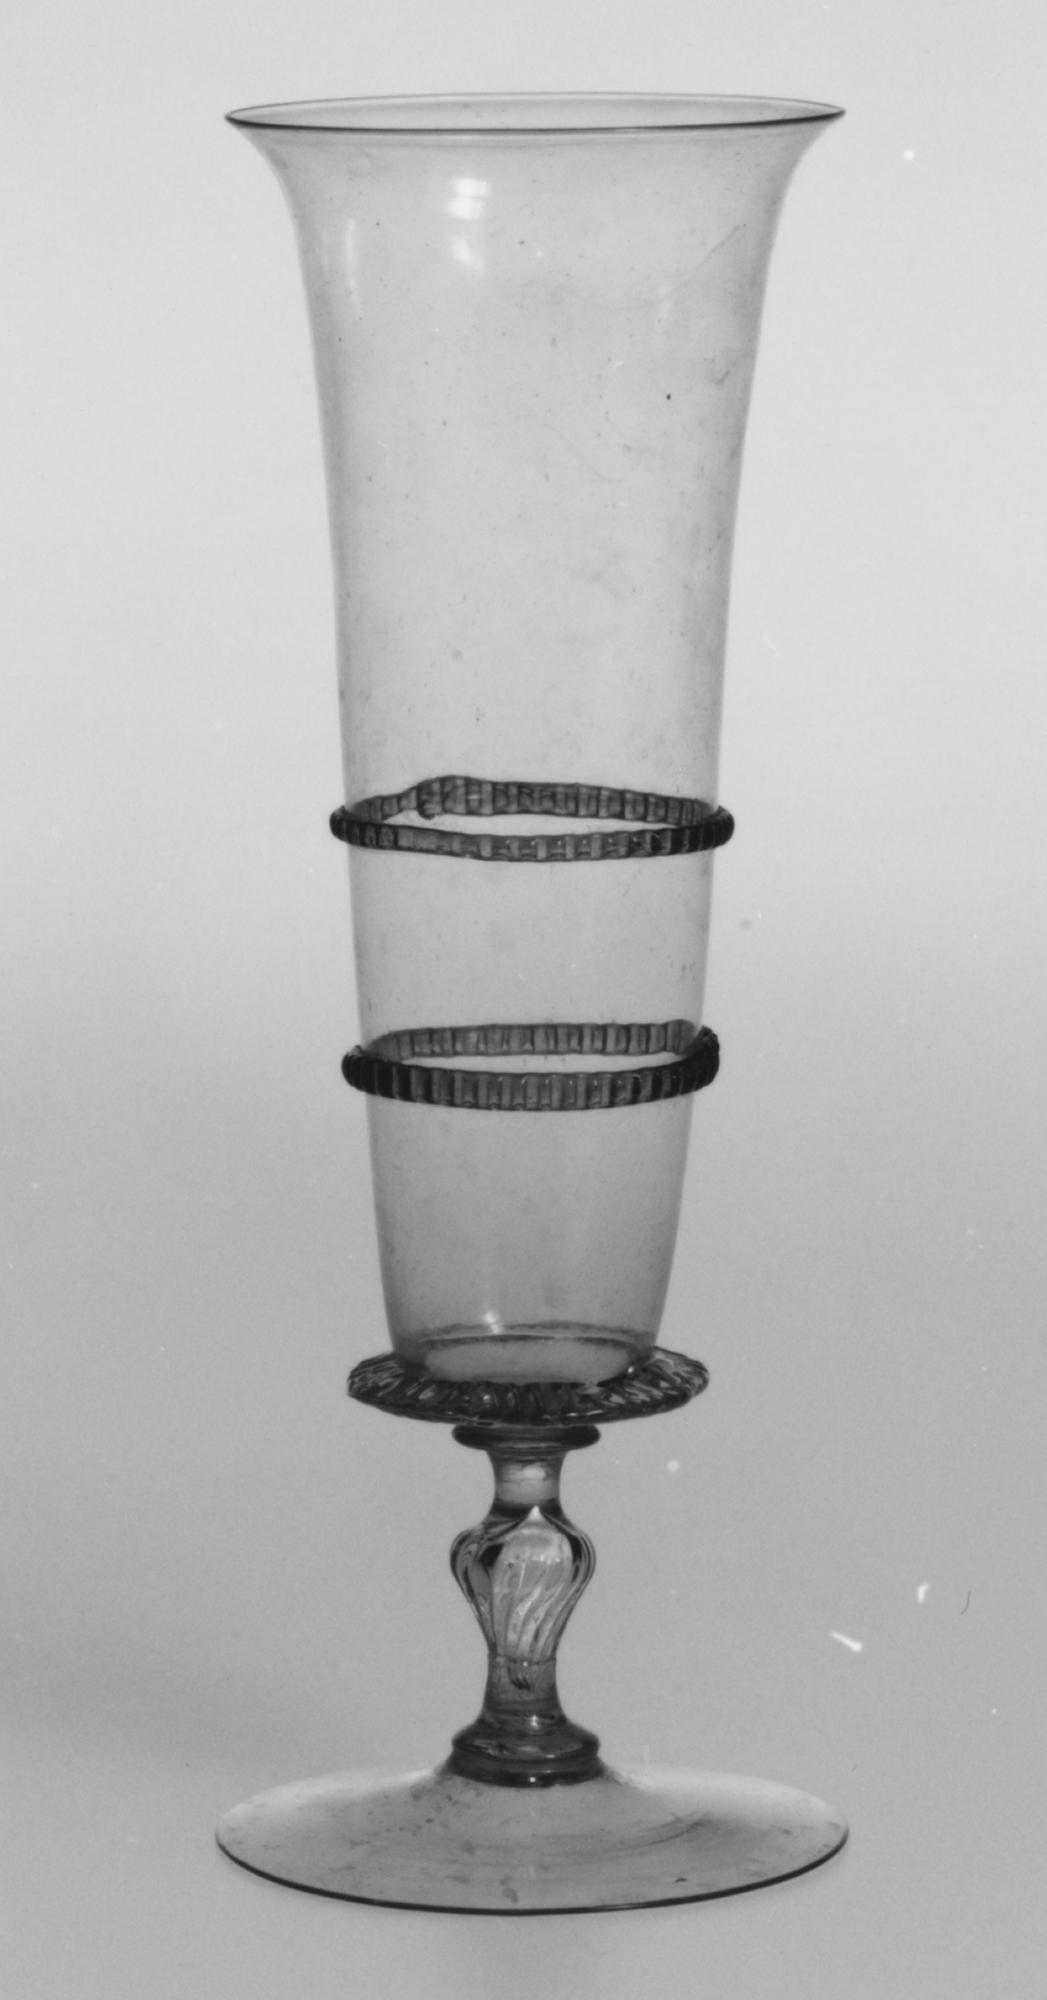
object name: wineglass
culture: façon de venise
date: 1601-1700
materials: glass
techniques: glassblowing, molding